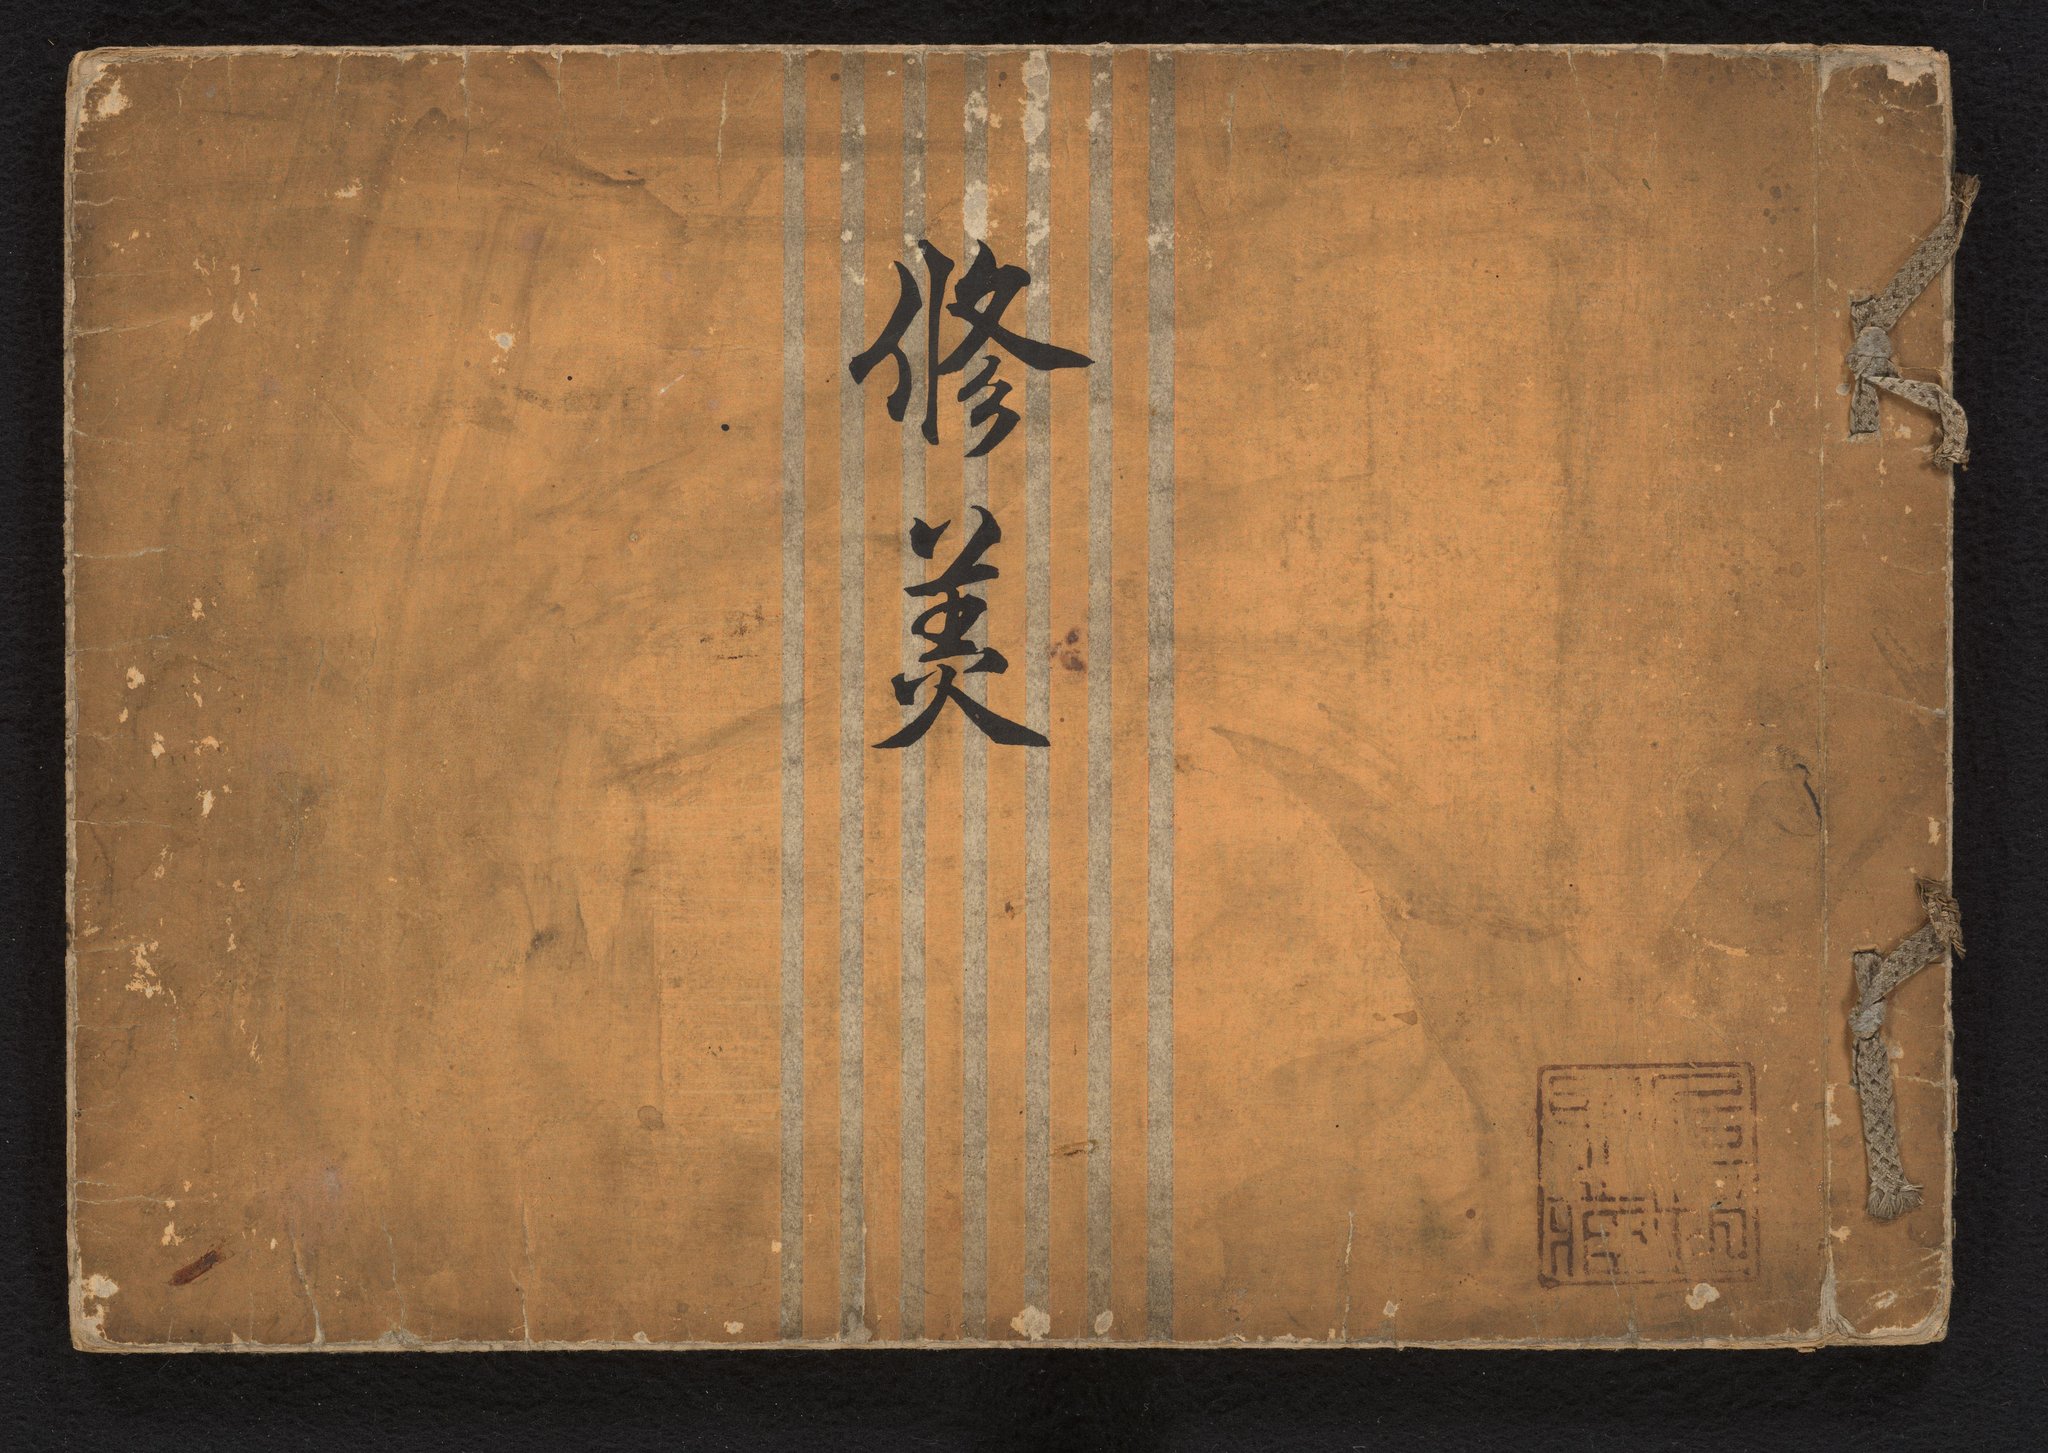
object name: book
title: Studie van schoonheid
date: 1906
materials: paper, pigment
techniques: woodcut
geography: japan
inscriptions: inscription: ‘明治参拾九年六月上野精江蔵’